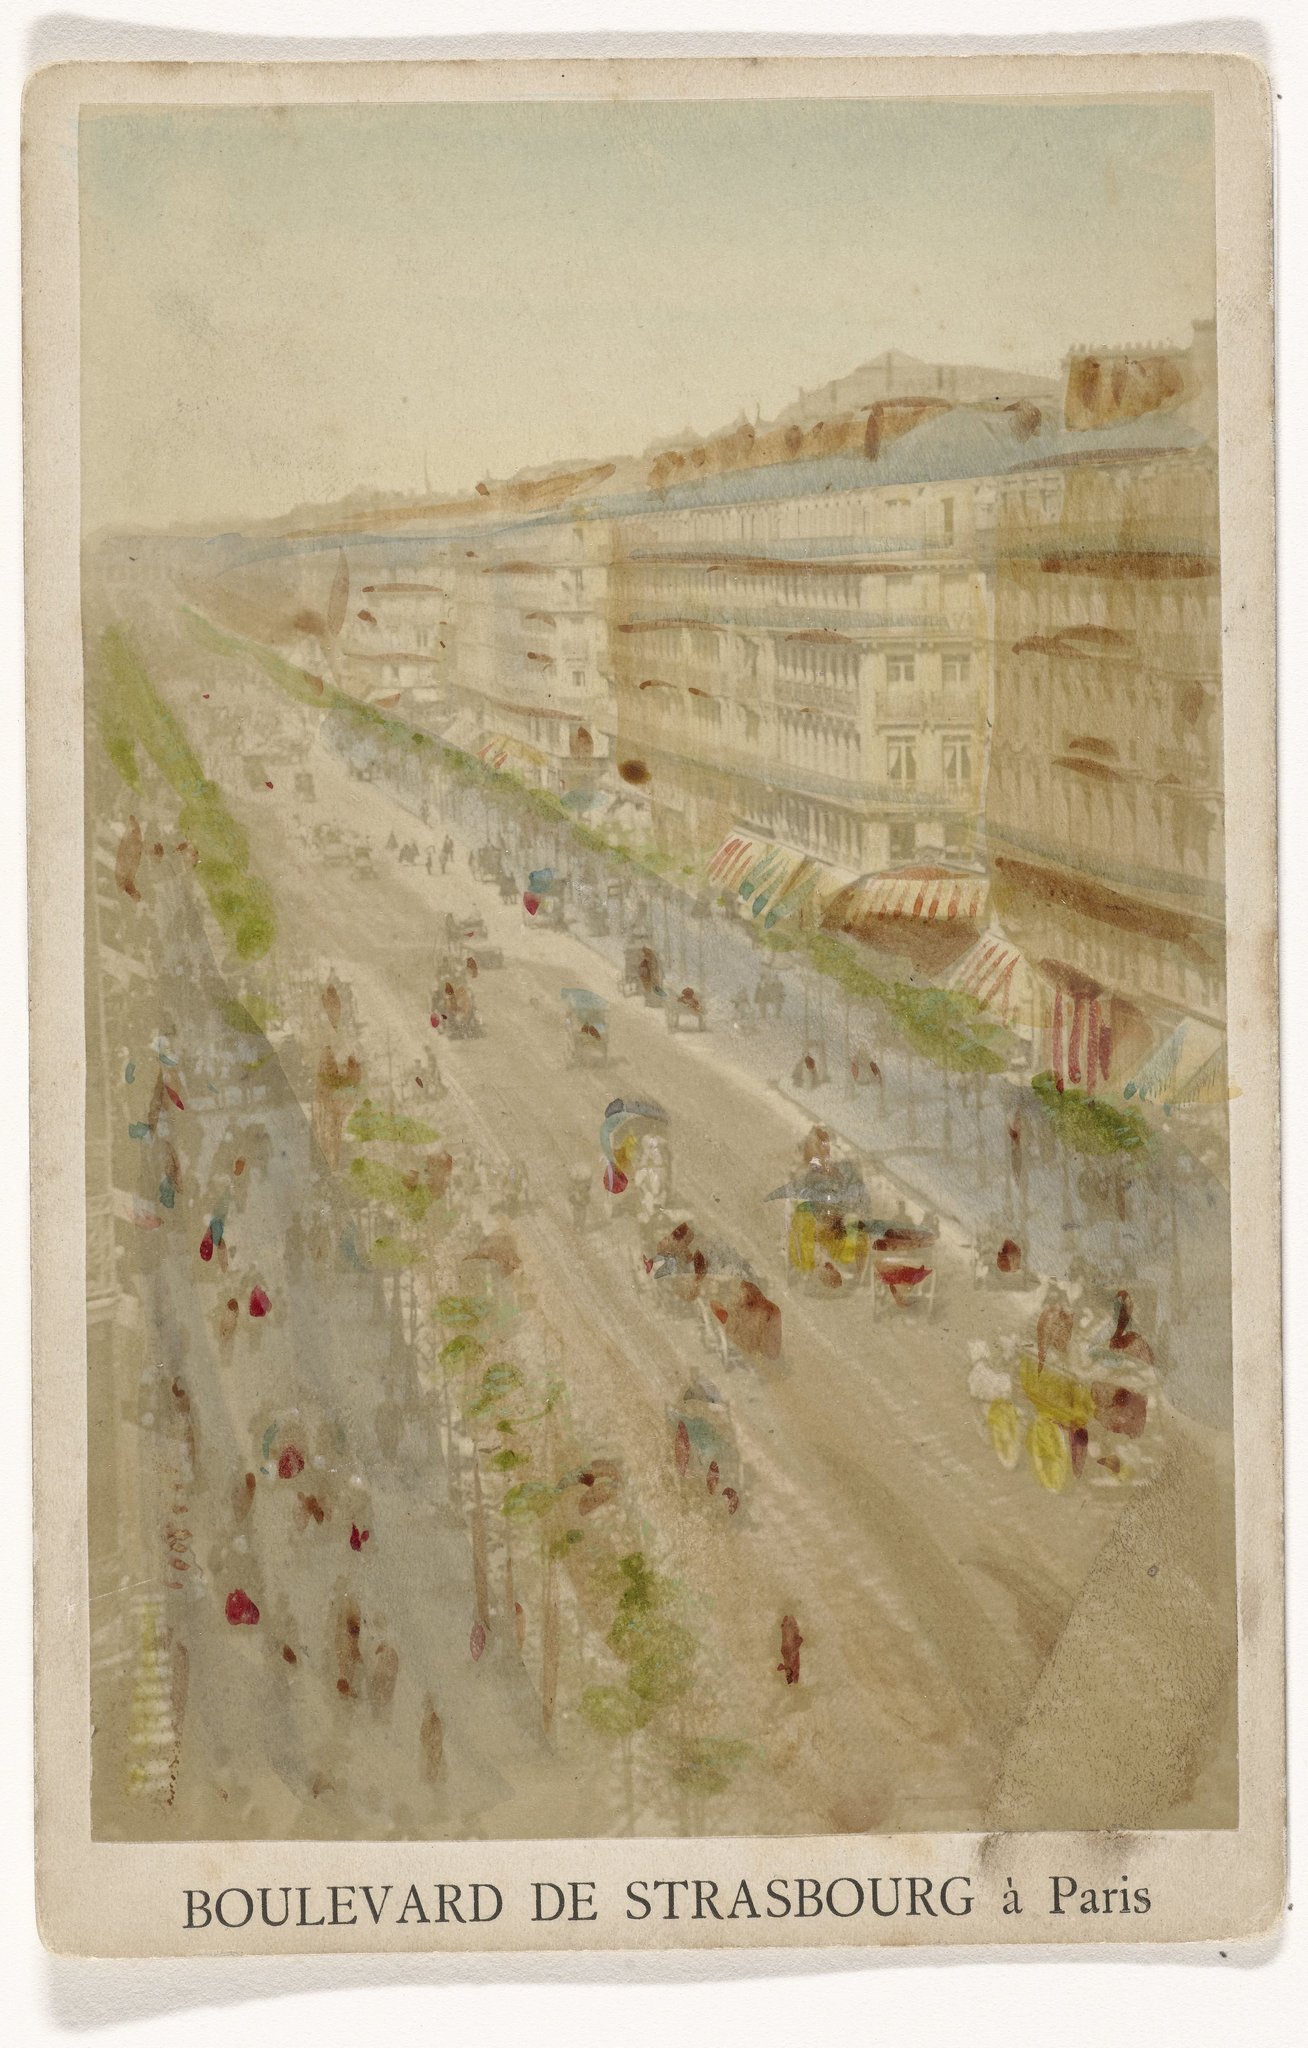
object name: cabinet photograph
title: Gezicht op de Boulevard de Strasbourg in Parijs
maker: Anonymous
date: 1866-1870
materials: cardboard, paper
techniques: albumen print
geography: paris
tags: street, paris